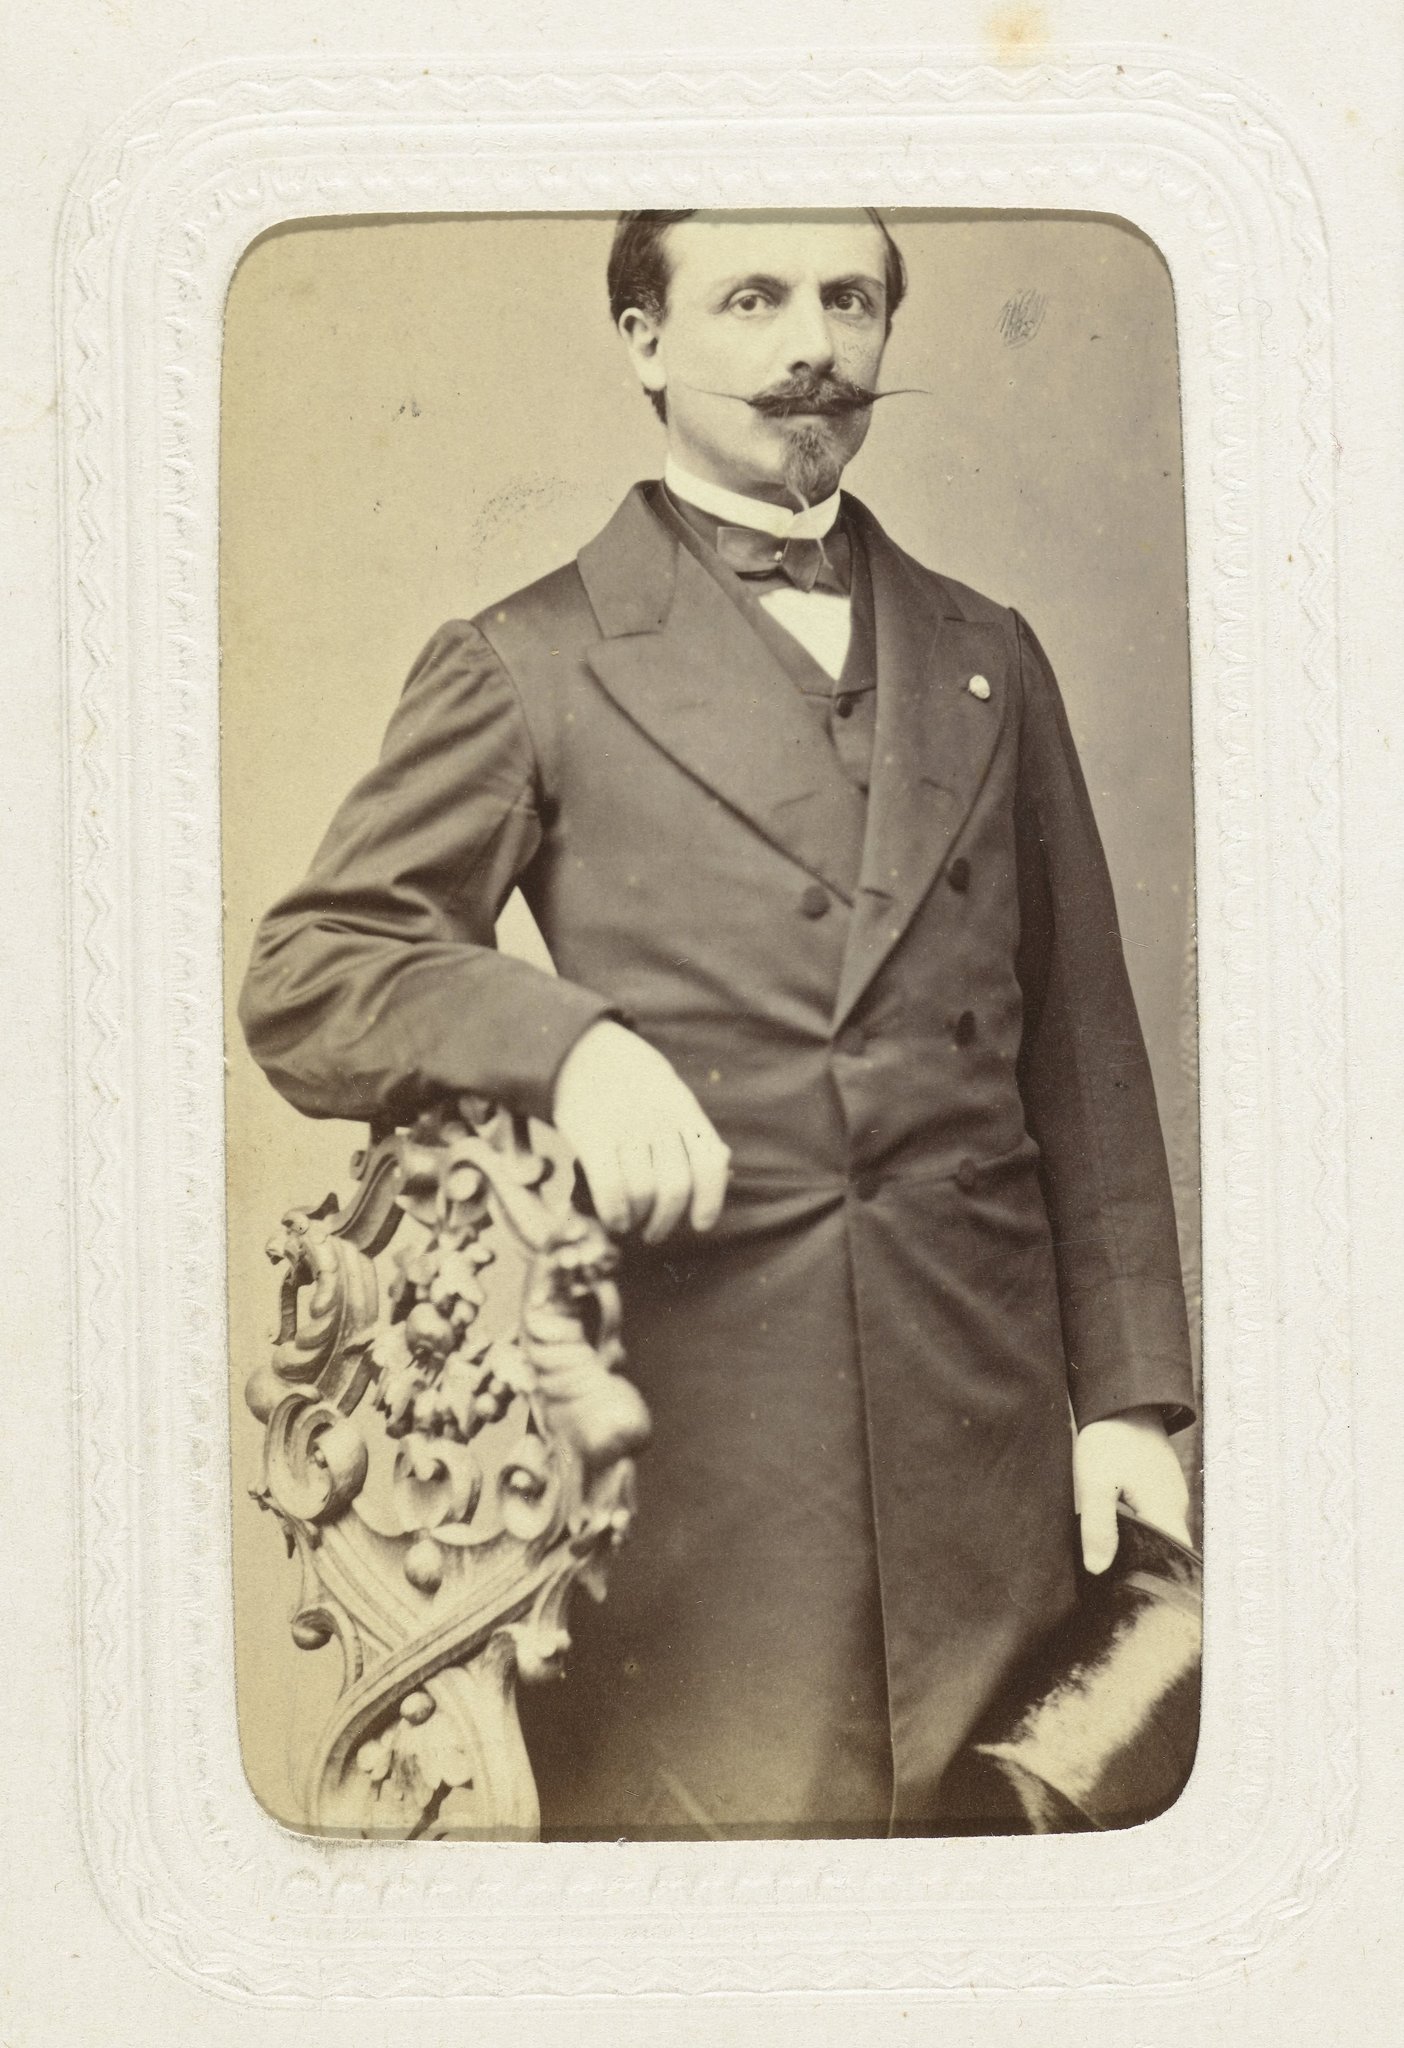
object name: carte de visite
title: Studioportret van een man met een gedraaide snor en een sik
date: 1863-1866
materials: cardboard, paper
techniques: albumen print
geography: istanbul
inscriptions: name: ‘Abdullah freres, Constantinople’